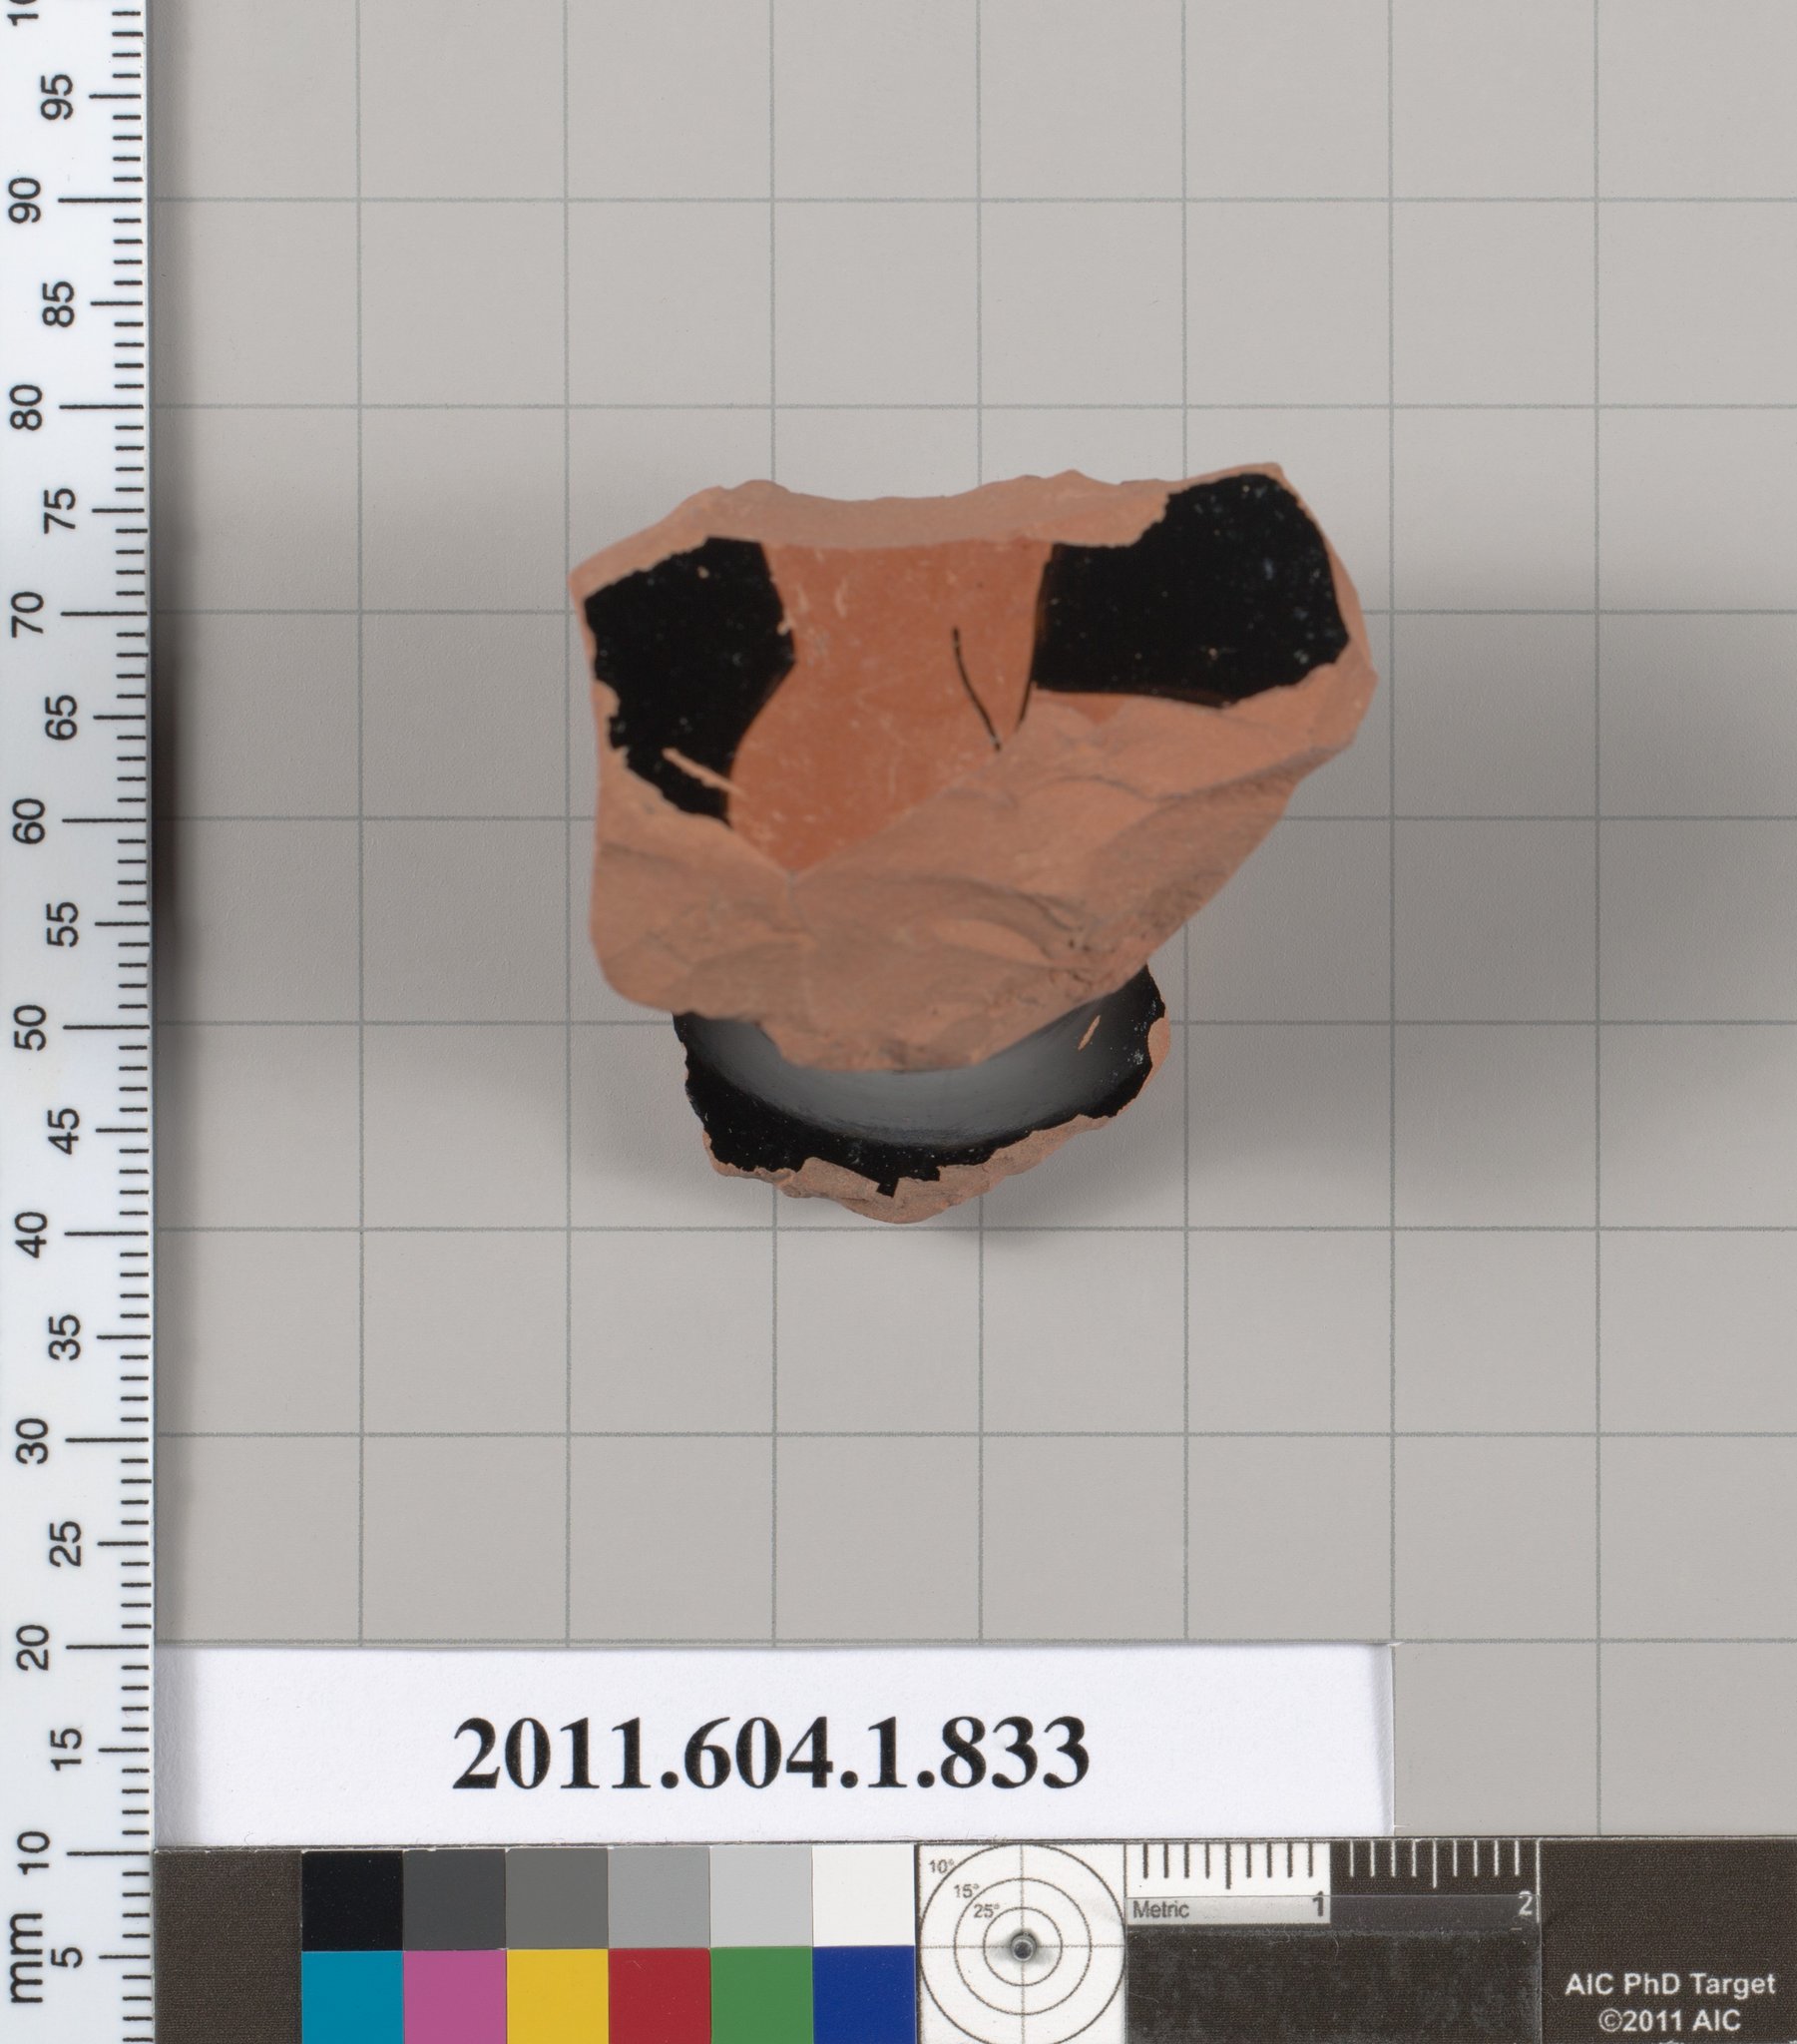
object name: kylix fragment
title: Terracotta fragment of a kylix (drinking cup)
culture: greek, attic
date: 475-451 BCE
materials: terracotta